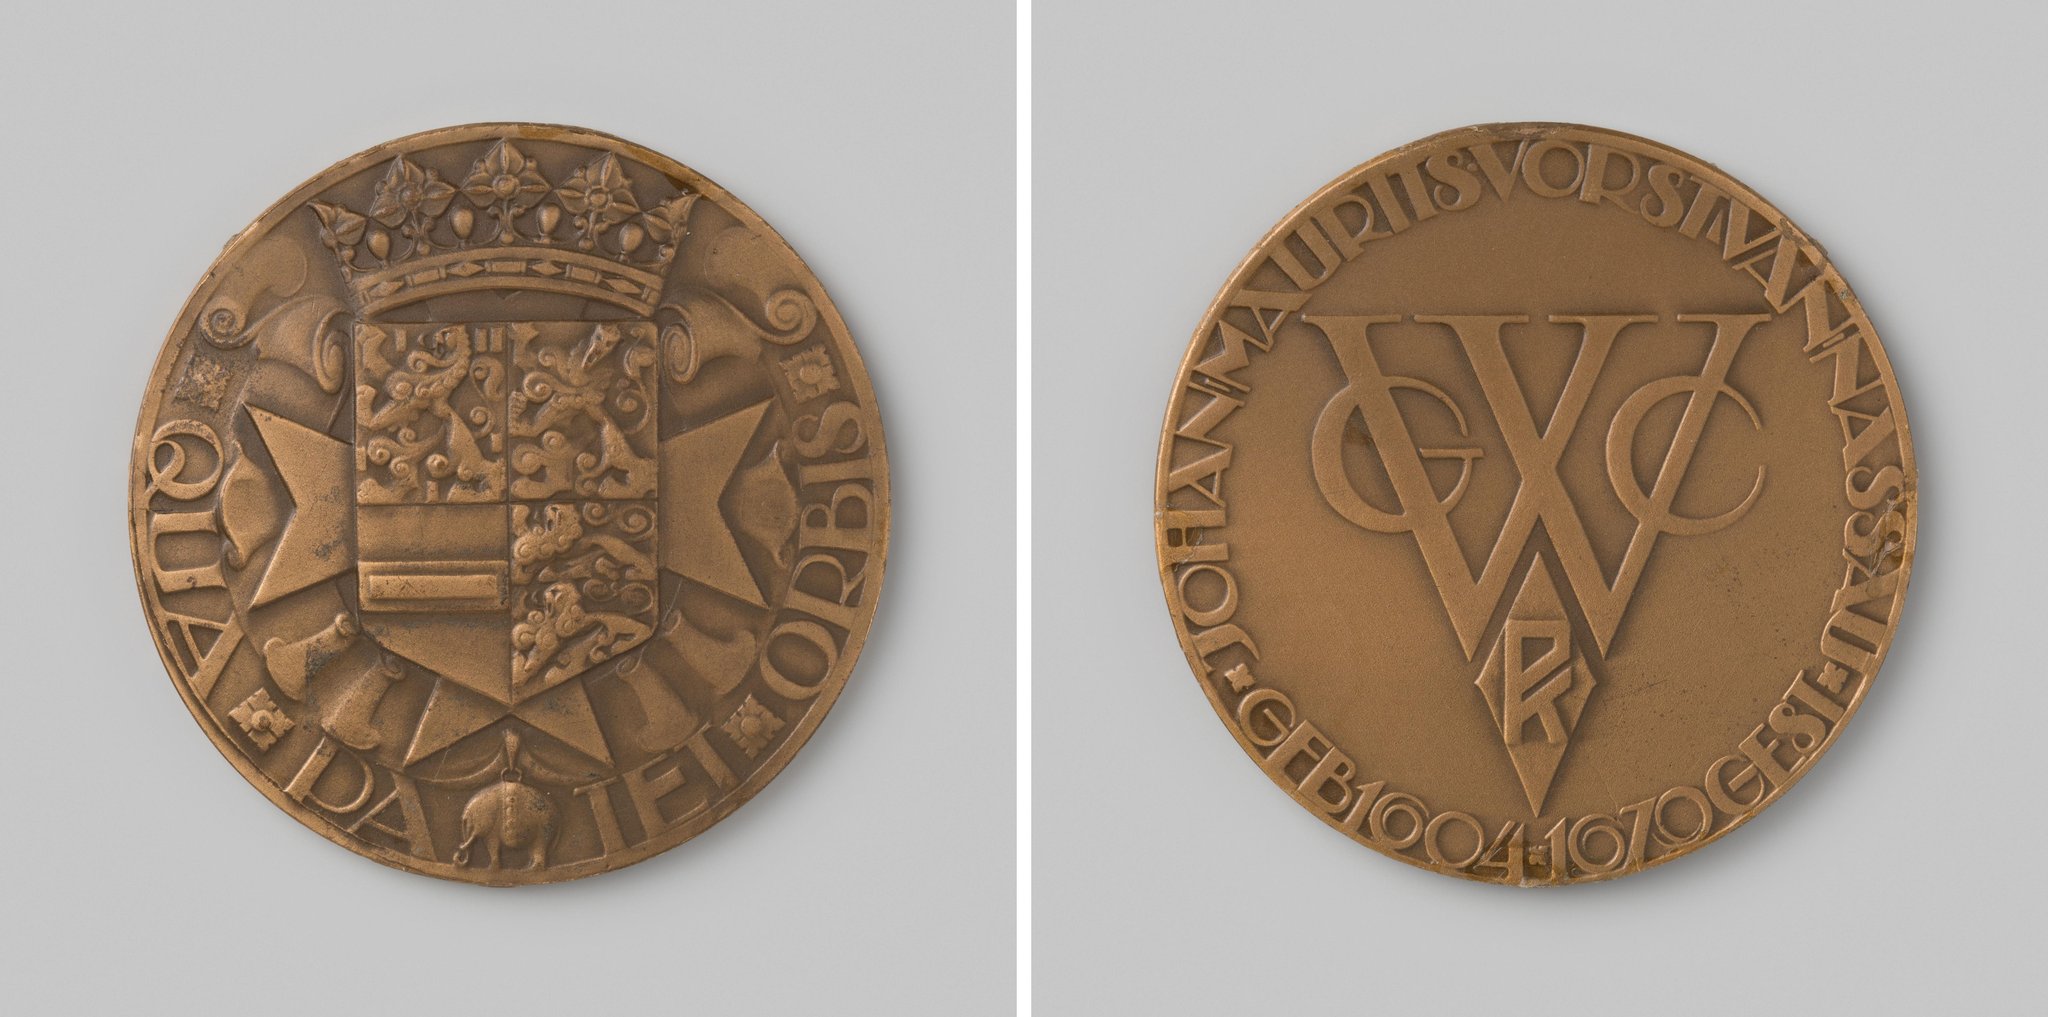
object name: medal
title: Johan Maurits van Nassau tweehonderdvijftig jaar overleden (Vereniging voor Penningkunst 1929, tweede penning)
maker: chris van der hoef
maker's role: ceramicist, draughtsman, sculptor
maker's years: 1875-1933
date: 1929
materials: bronze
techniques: striking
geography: voorschoten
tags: earl, johan maurits graaf van nassau-siegen